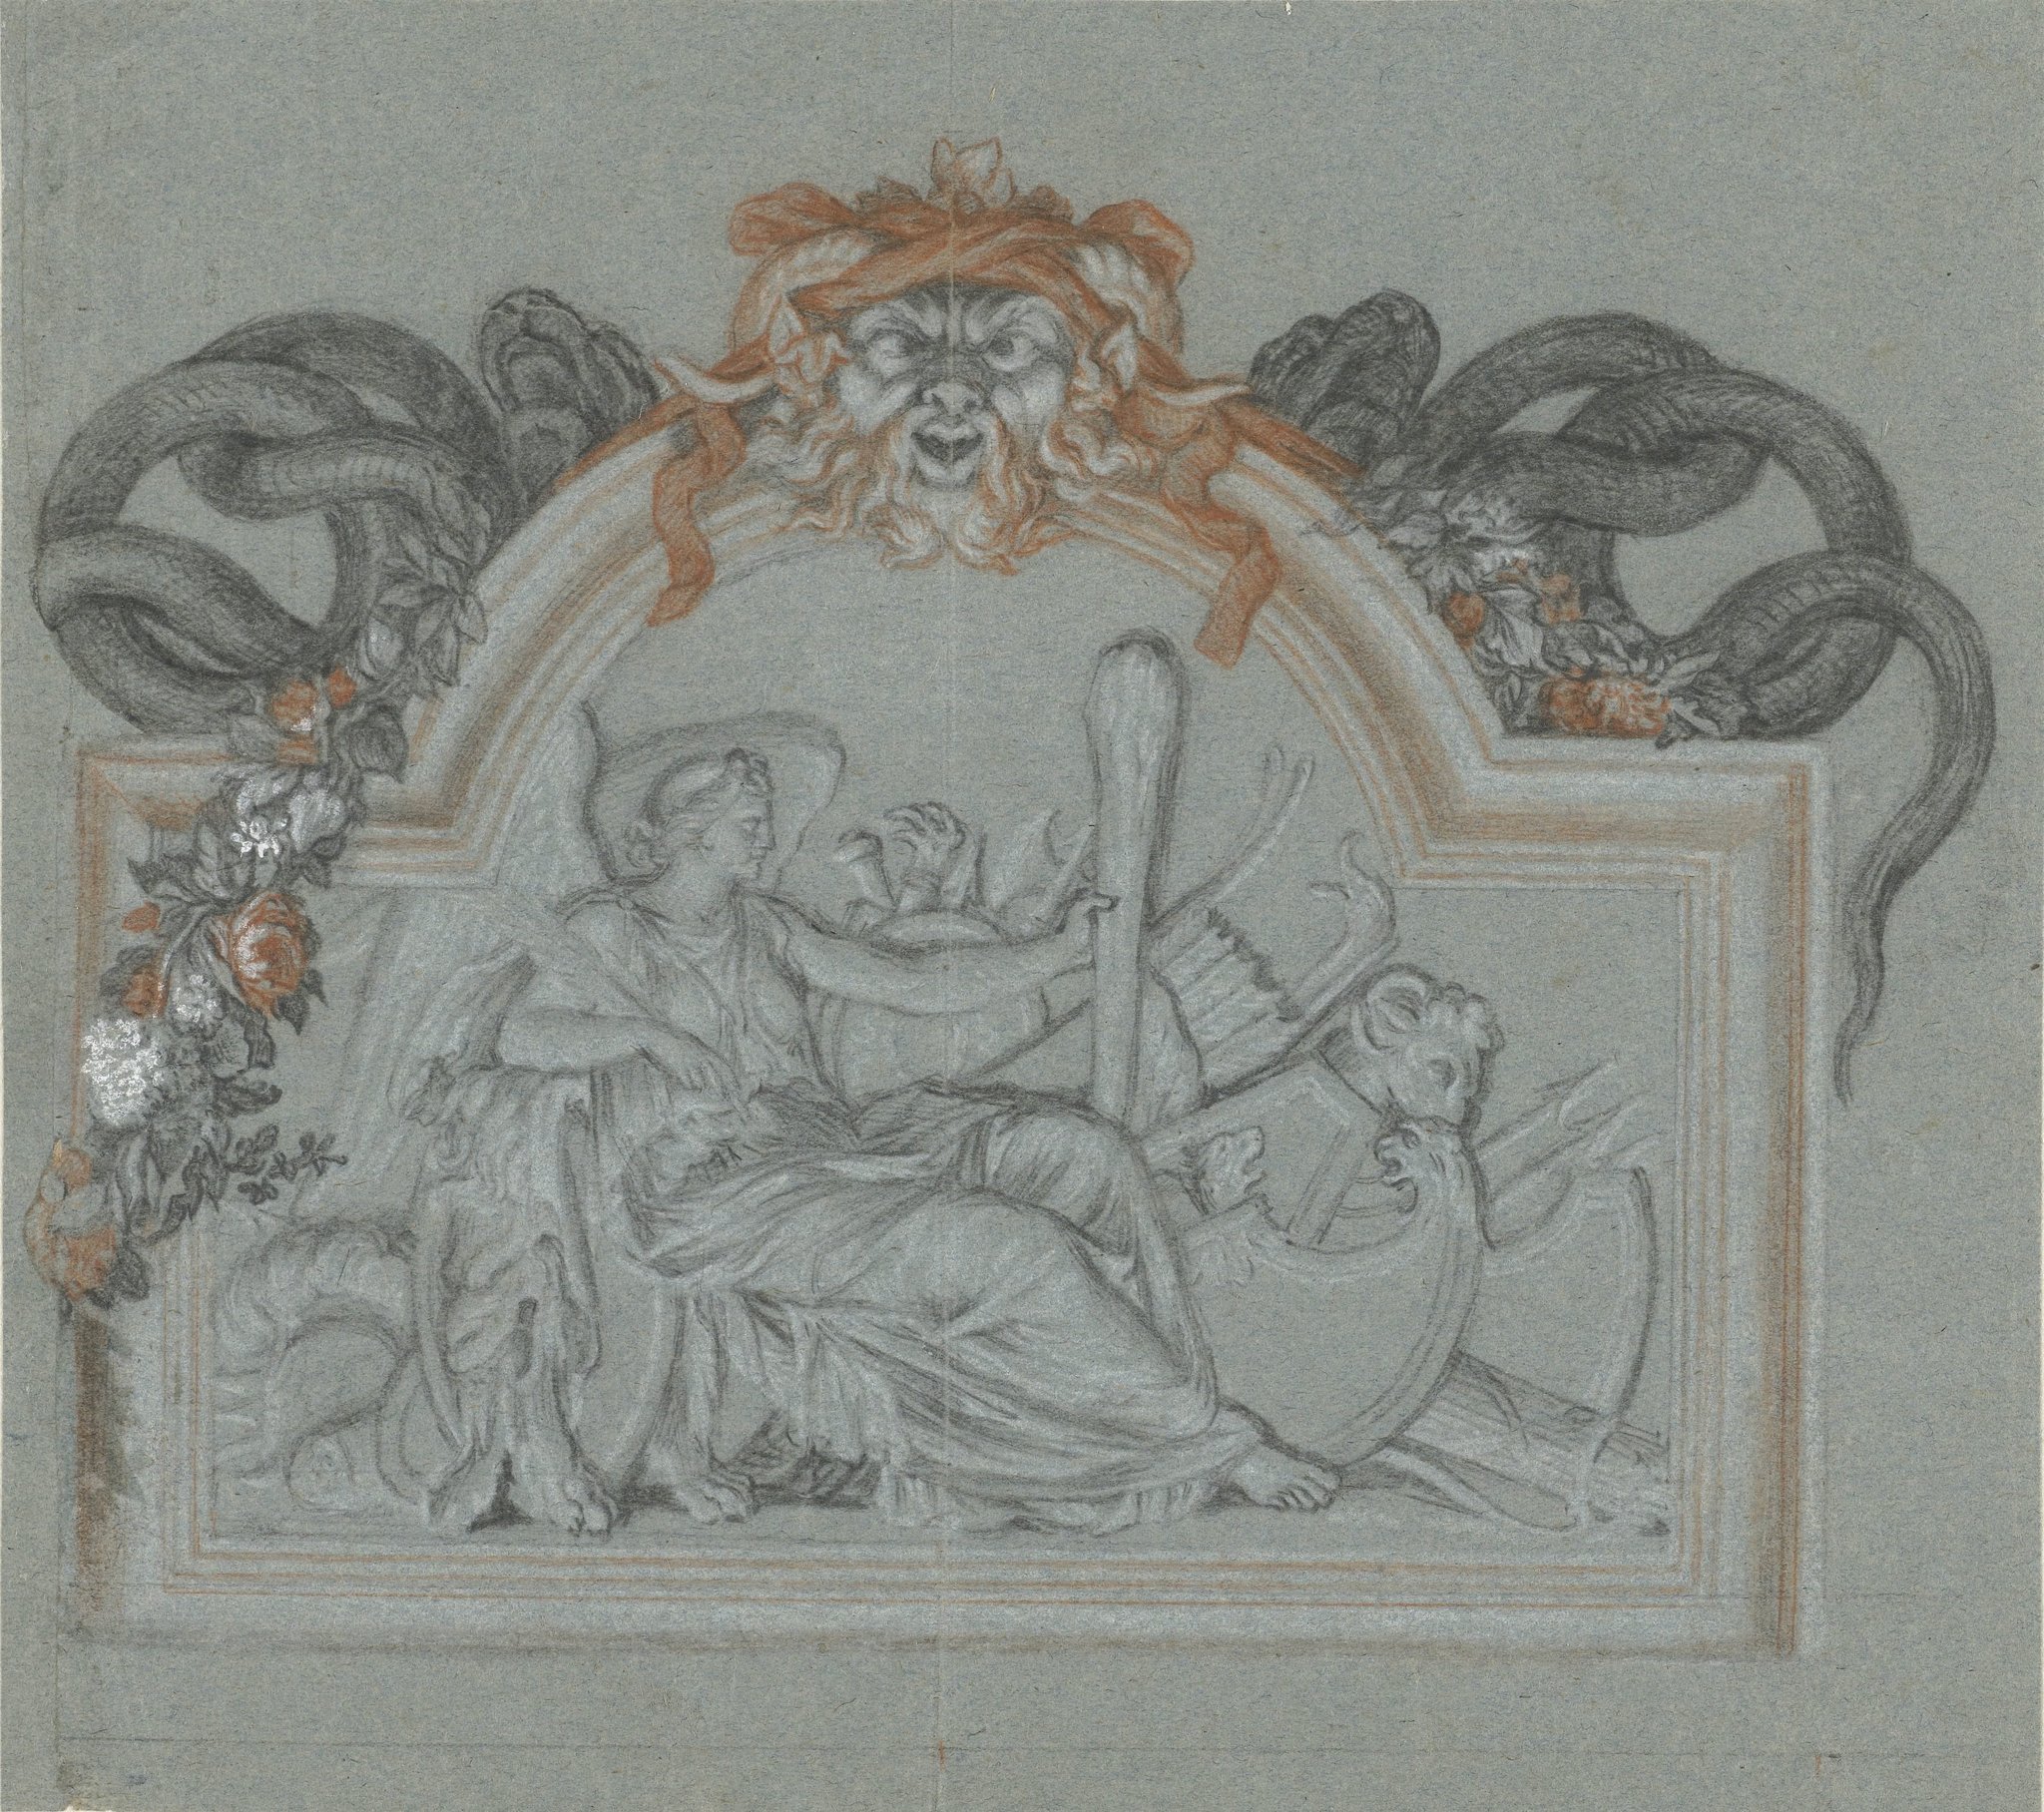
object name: drawing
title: Paneel met de personificatie van de Kracht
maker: bernard picart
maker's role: draughtsman, print maker, publisher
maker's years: 1673-1733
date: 1683-1733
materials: chalk, paper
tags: fortitude, 'fortitudo' ~ one of the four cardinal virtues